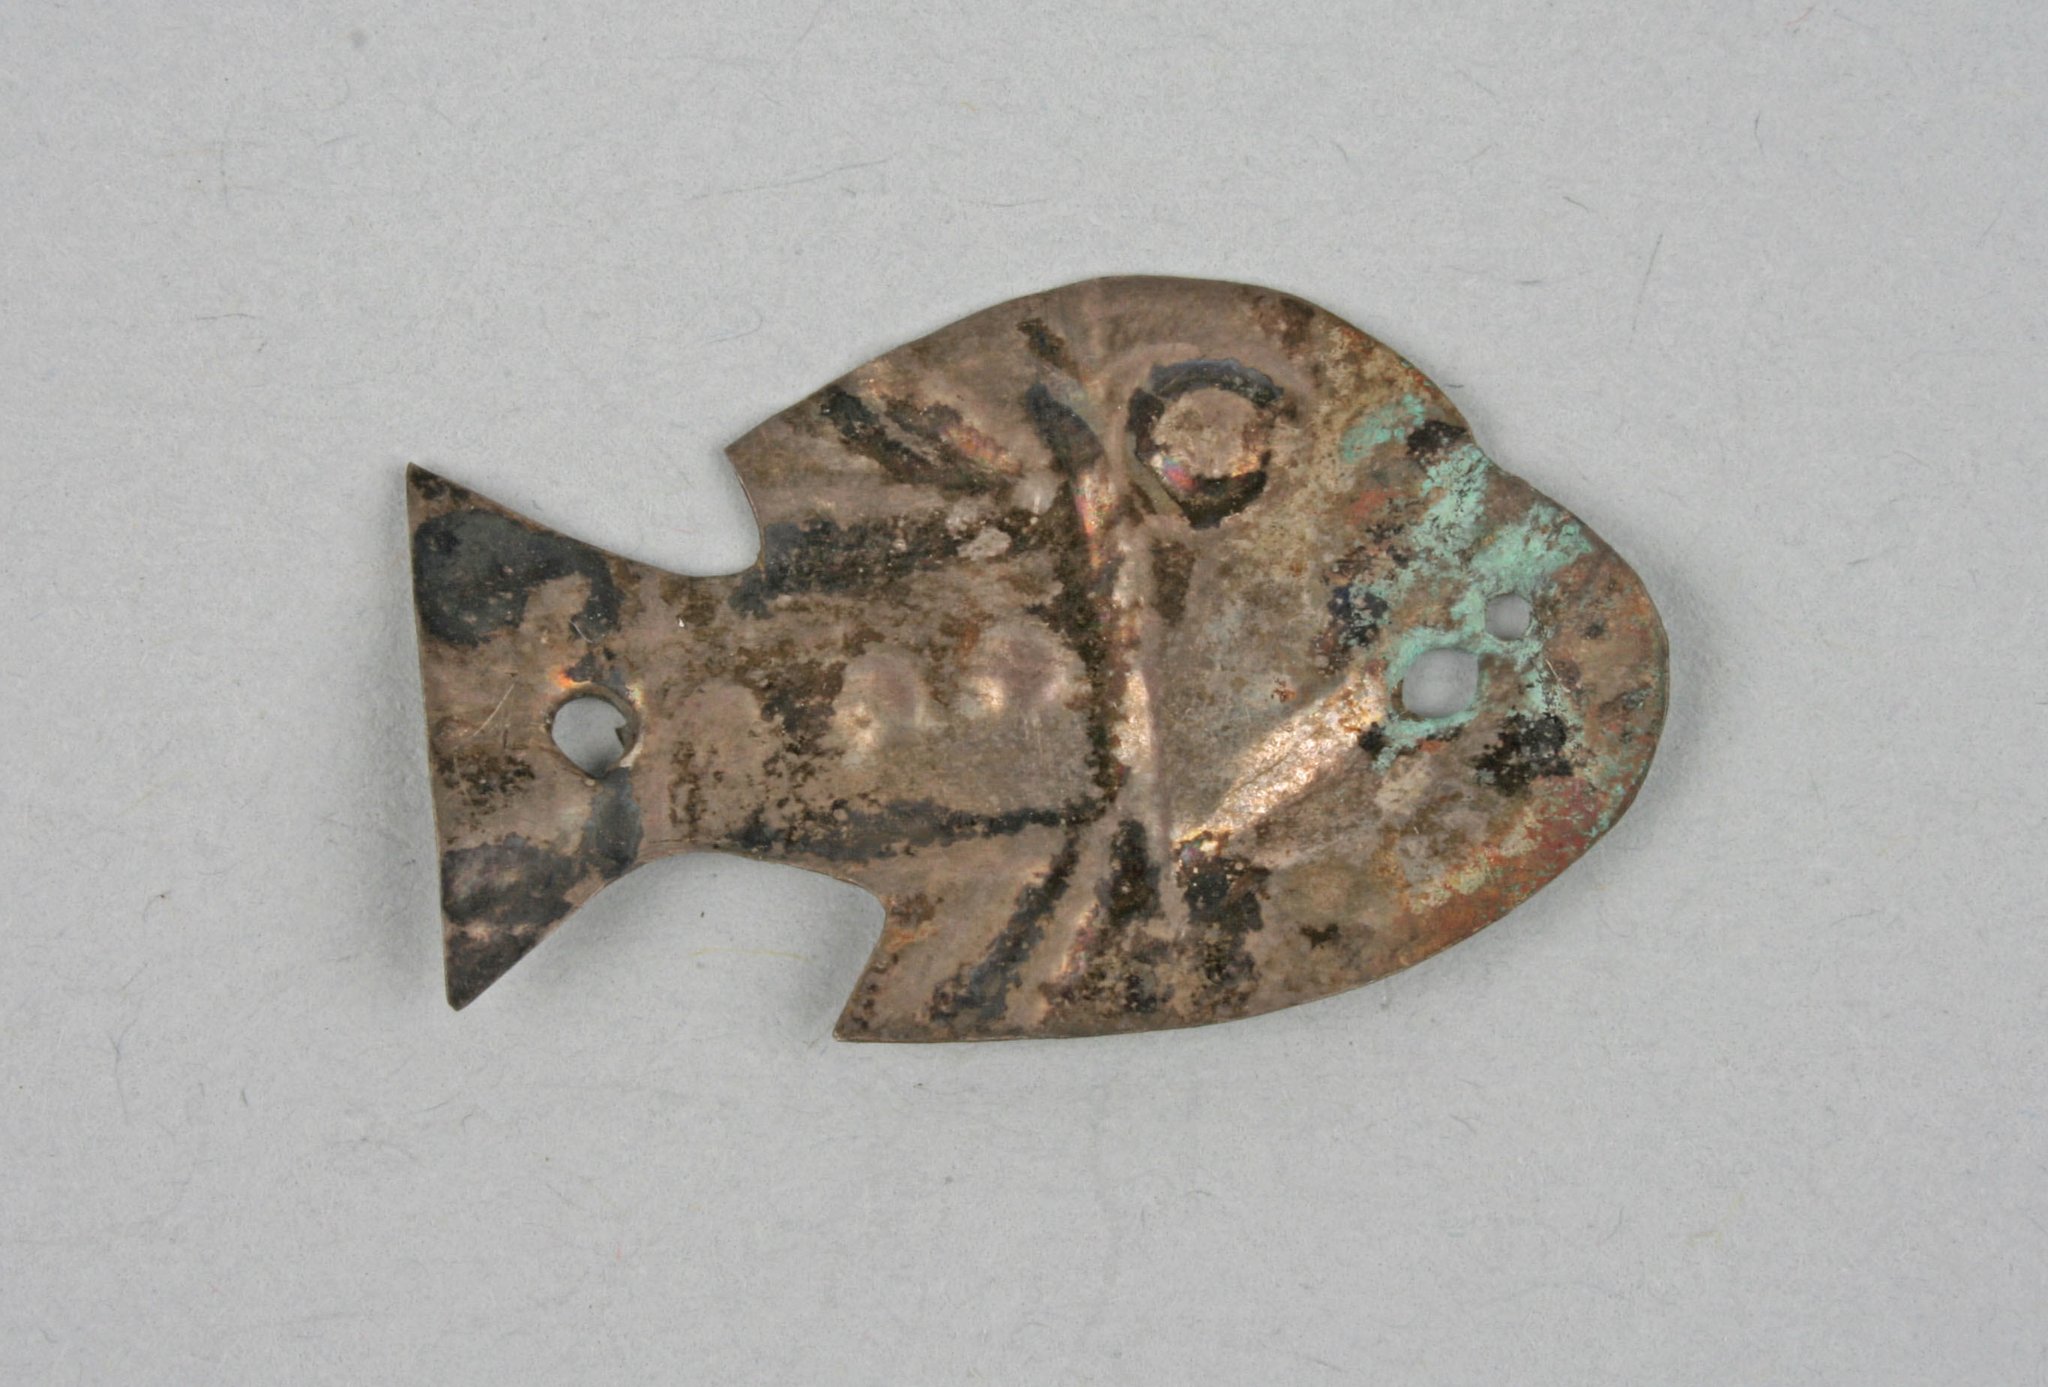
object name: ornament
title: Costume Ornament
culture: central coast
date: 1001-1200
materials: silver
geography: peru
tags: fish